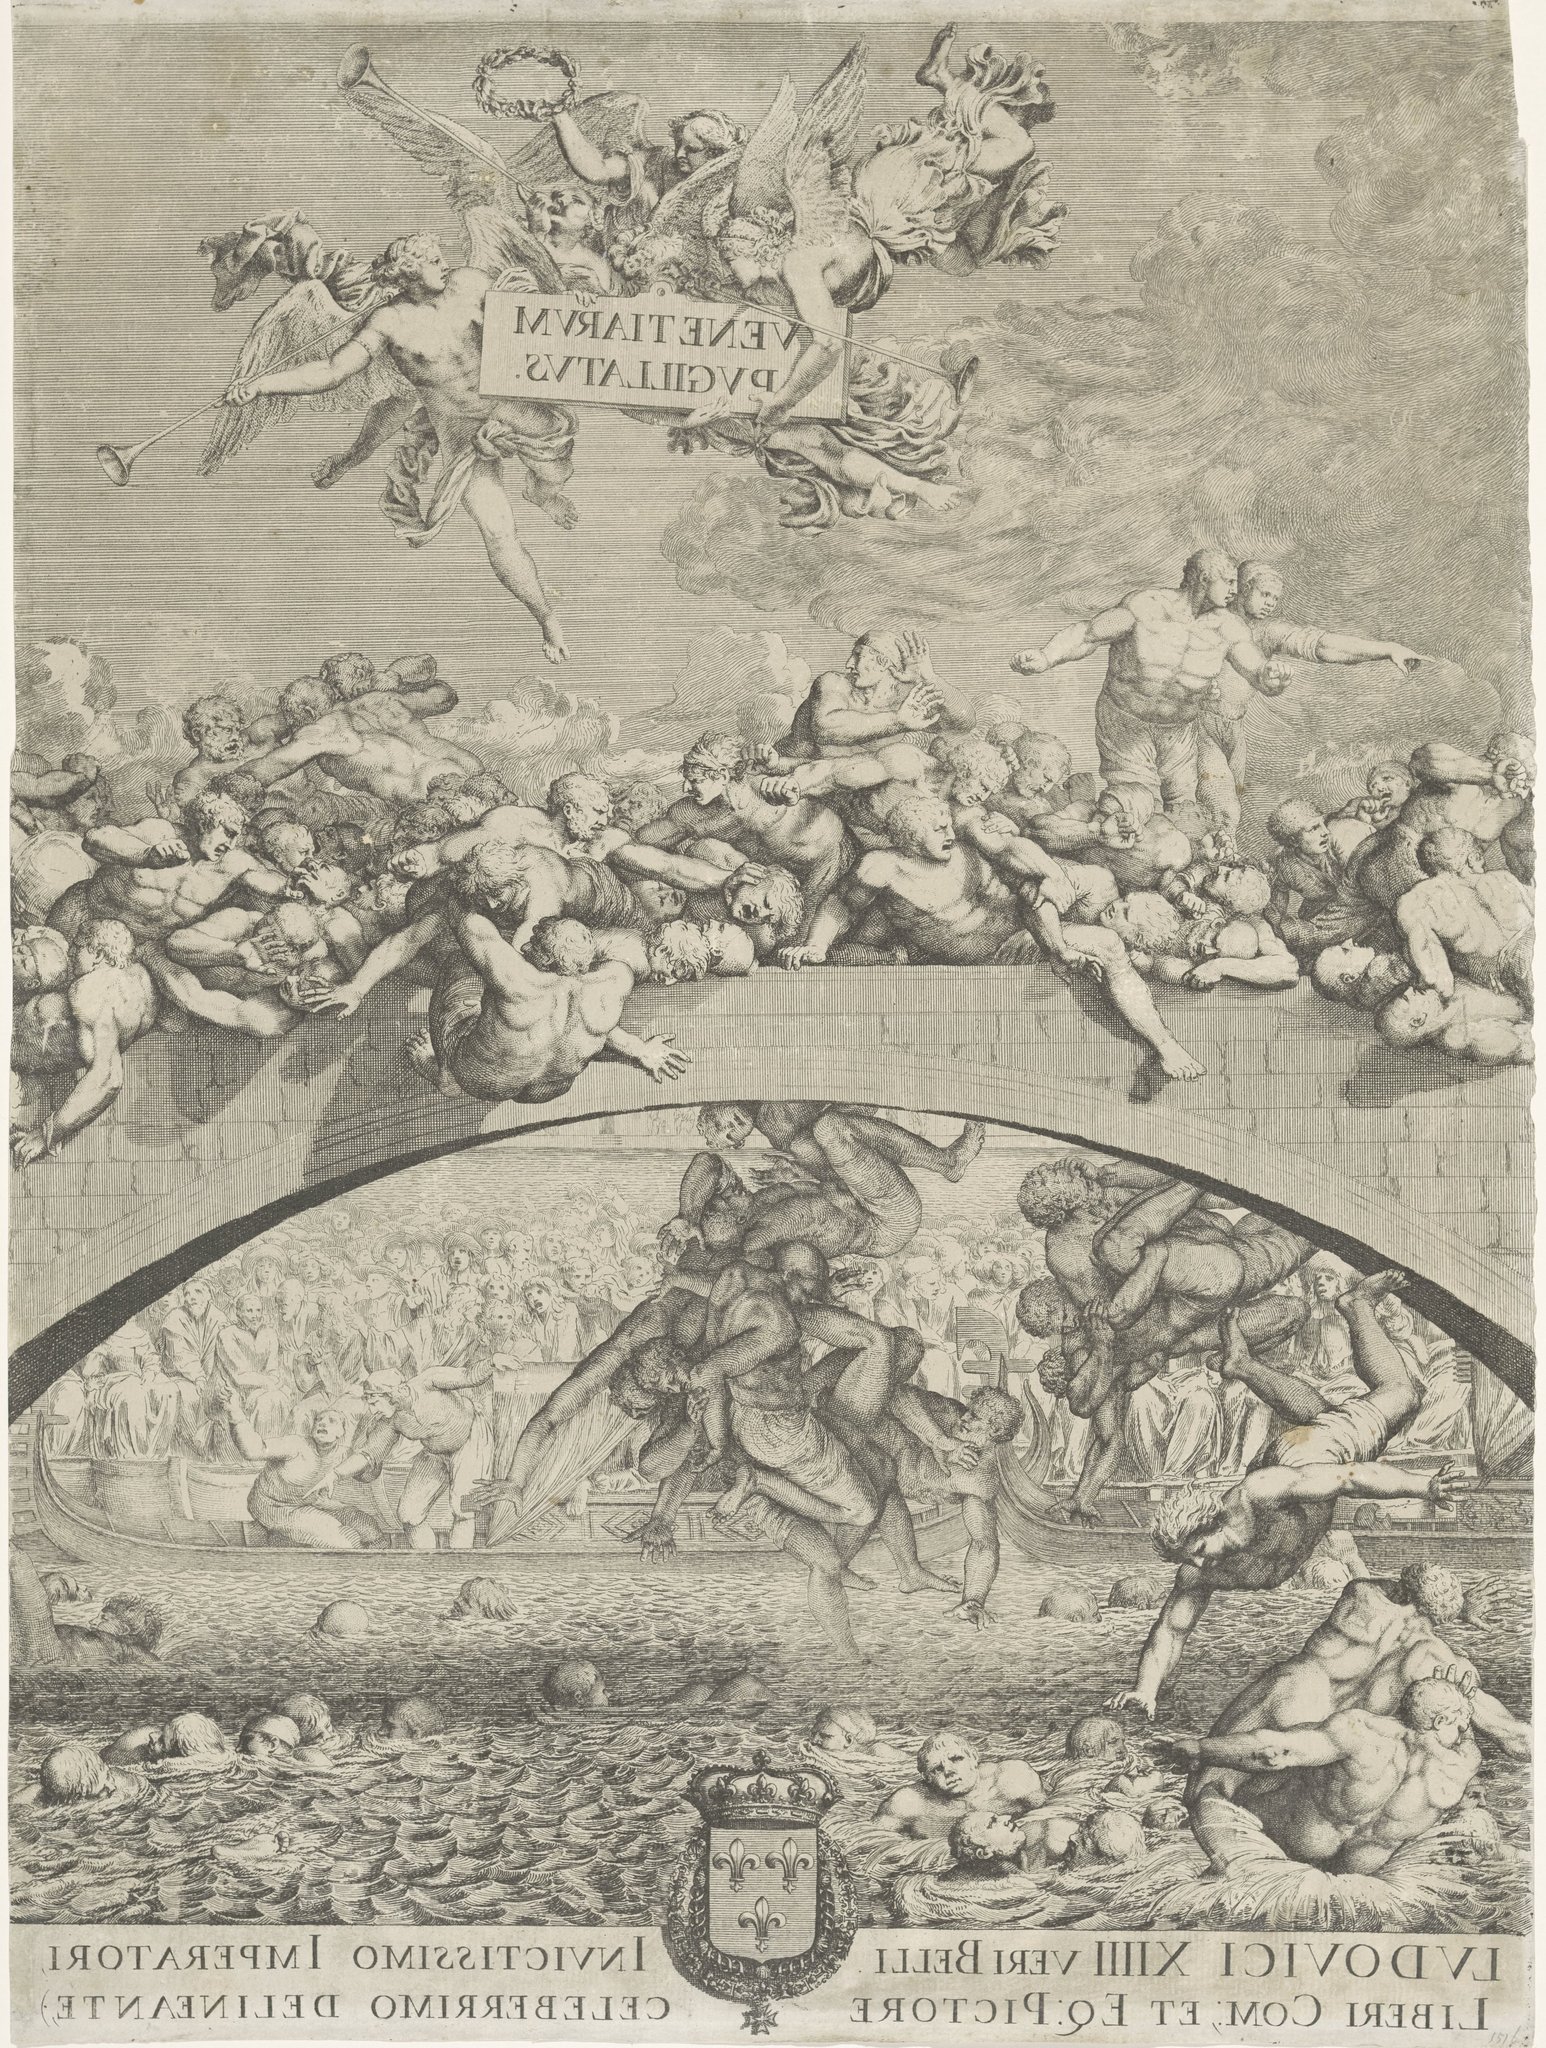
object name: print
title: Vechtpartij op brug in Venetië (midden deel spiegelbeeldig)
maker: domenico rossetti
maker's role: print maker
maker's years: 1650-1736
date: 1660-1736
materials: paper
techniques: printmaking, engraving, etching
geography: venice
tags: battle, bridge, fighting, venice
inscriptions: collector's mark: Lugt 240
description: Een grote kluwen mannen in gevecht op een brug in Venetië. Verschillende figuren vallen van de brug in het water. Op de achtergrond figuren op gondels op het water.